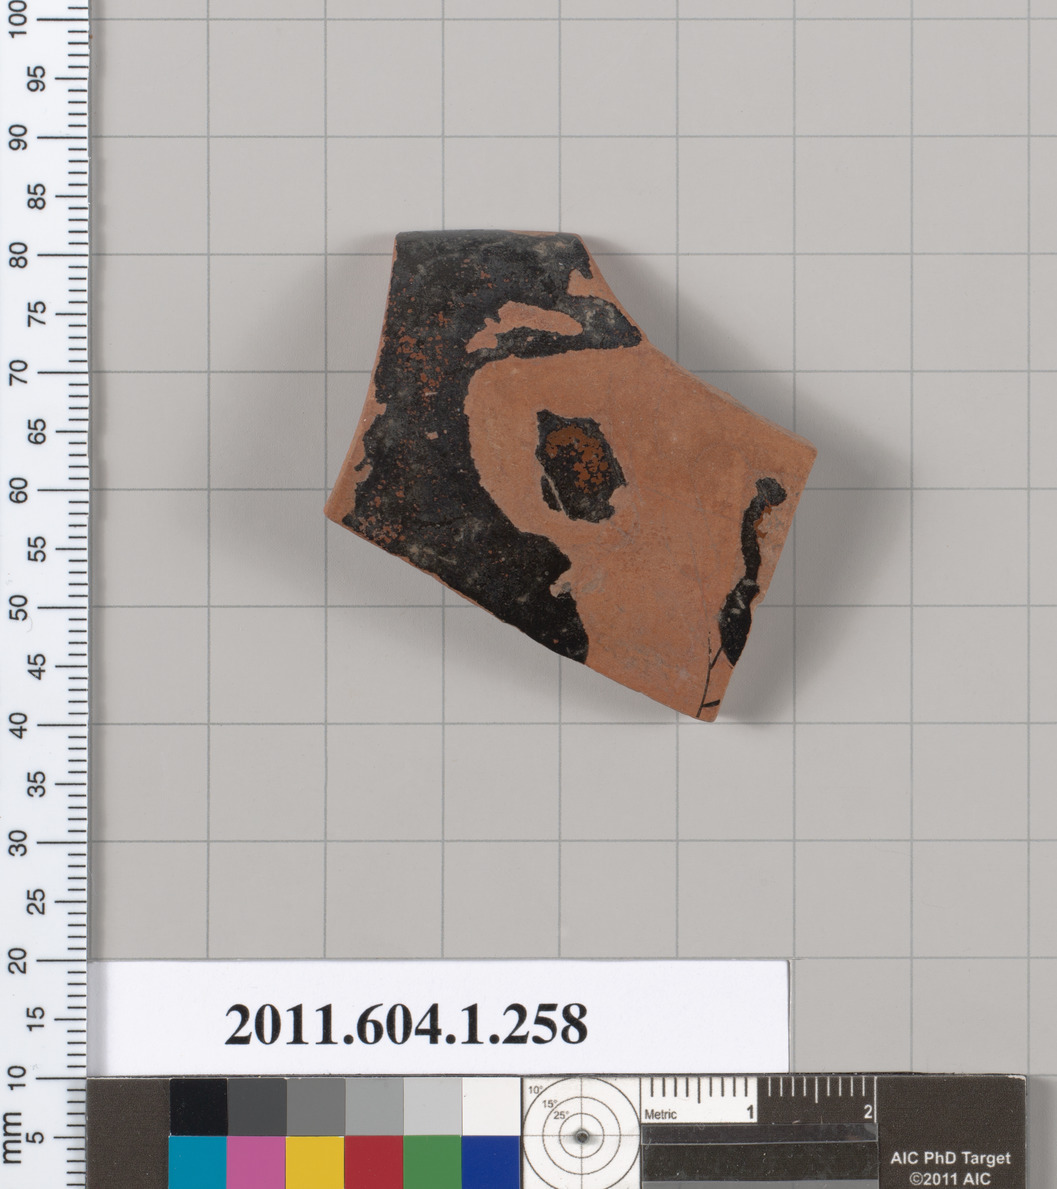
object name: kylix fragment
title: Terracotta rim fragment of a kylix (drinking cup)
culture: greek, attic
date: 475-451 BCE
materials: terracotta